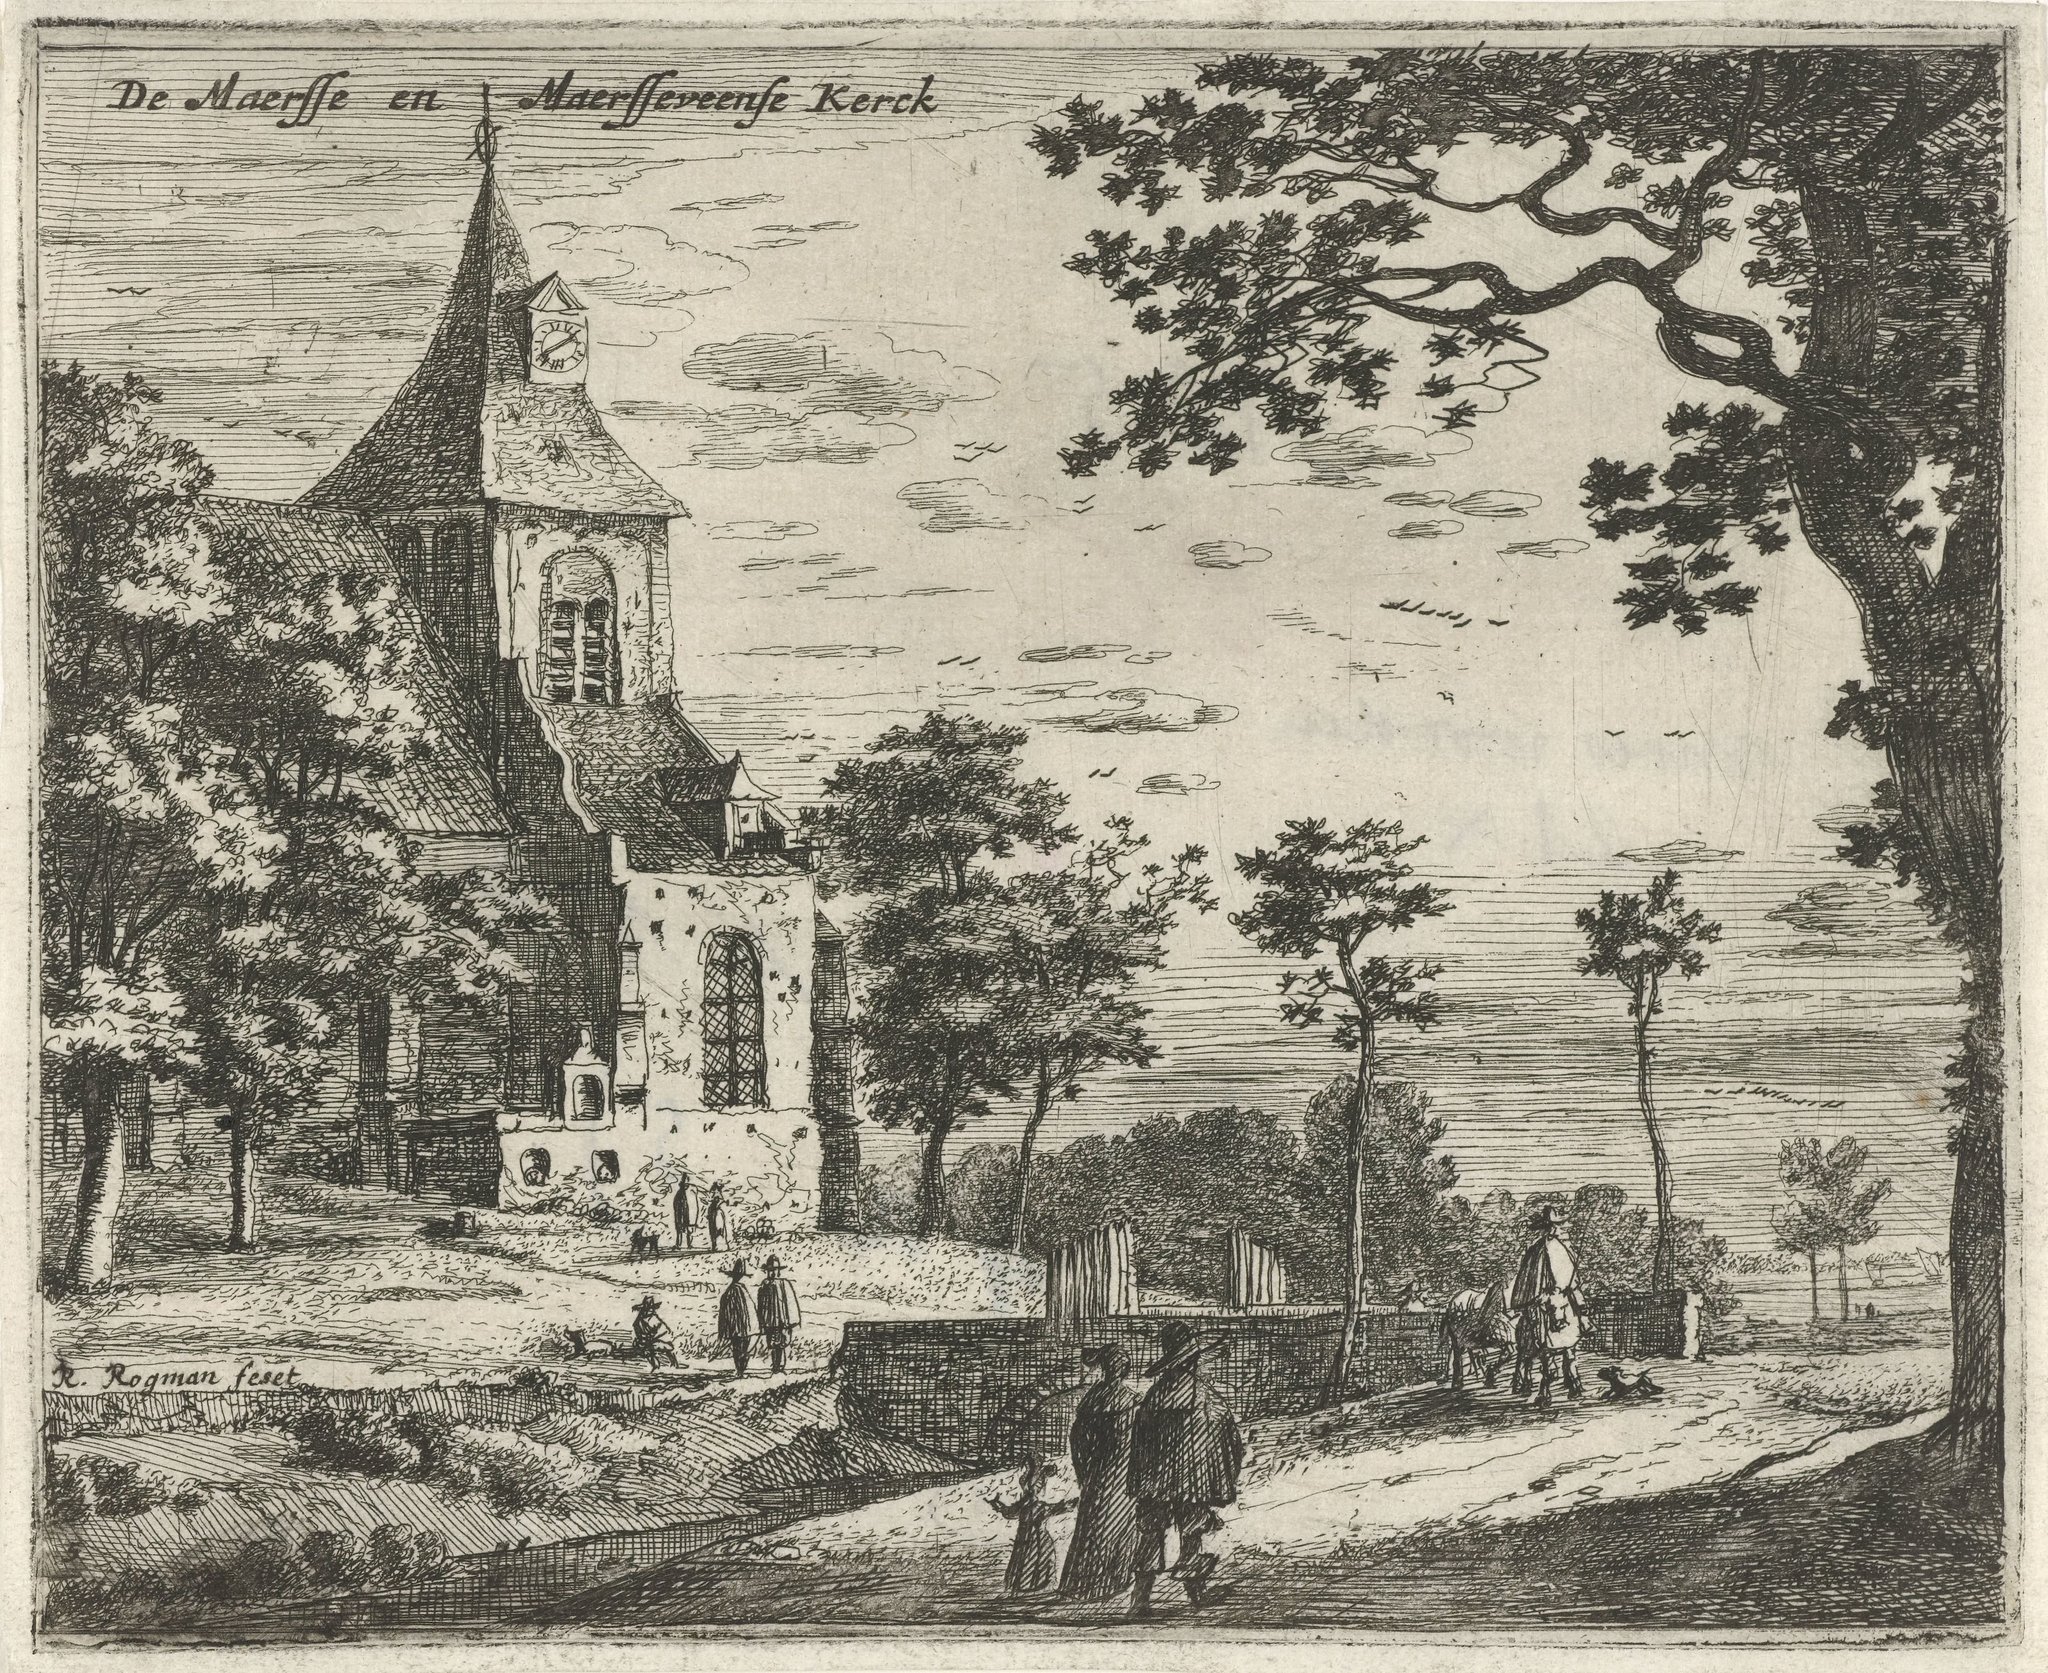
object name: print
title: Landschappen in de provincies Holland en Utrecht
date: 1637-1677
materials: paper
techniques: engraving, etching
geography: amsterdam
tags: riding a horse, ass, or mule; rider, horseman, church (exterior)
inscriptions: collector's mark: Lugt 2228a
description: Gezicht op de kerk van Maarsseveen (tegenwoordig deel van Maarssen), gelegen aan een kanaal. Rechts een landweg met enkele figuren en een ruiter.